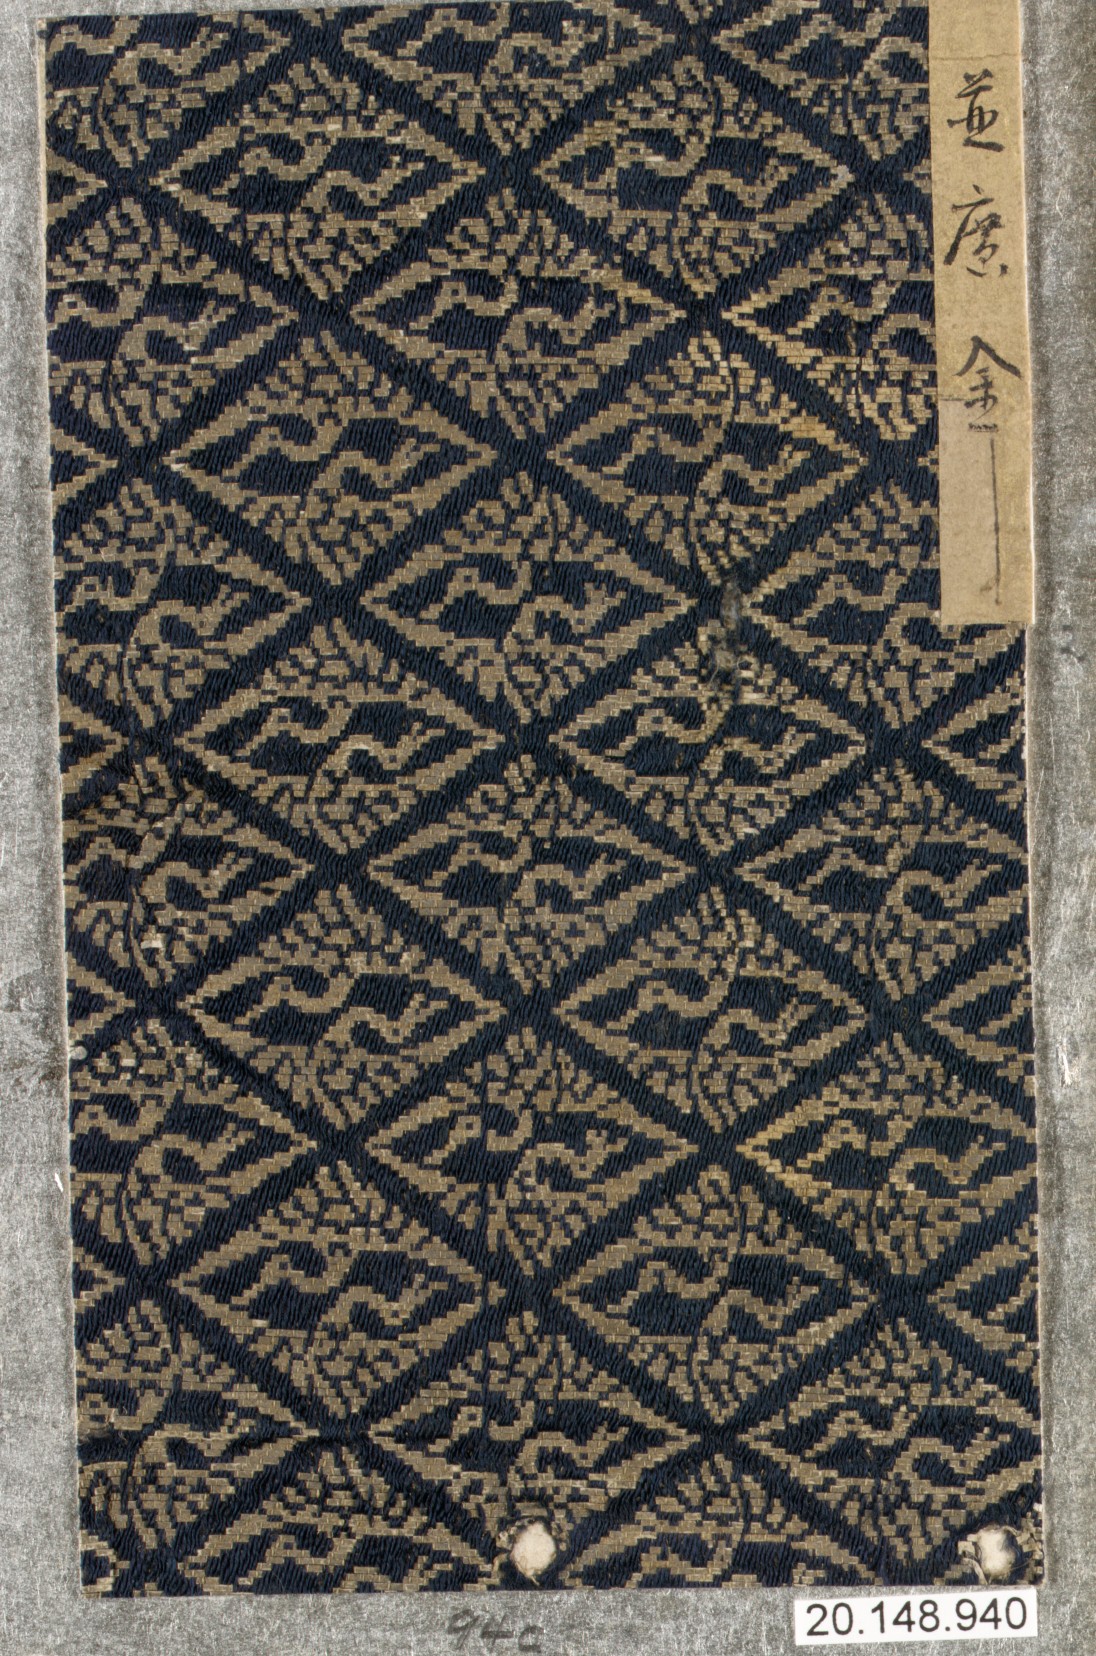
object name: piece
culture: japanese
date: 1601-1700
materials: silk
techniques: compound weave